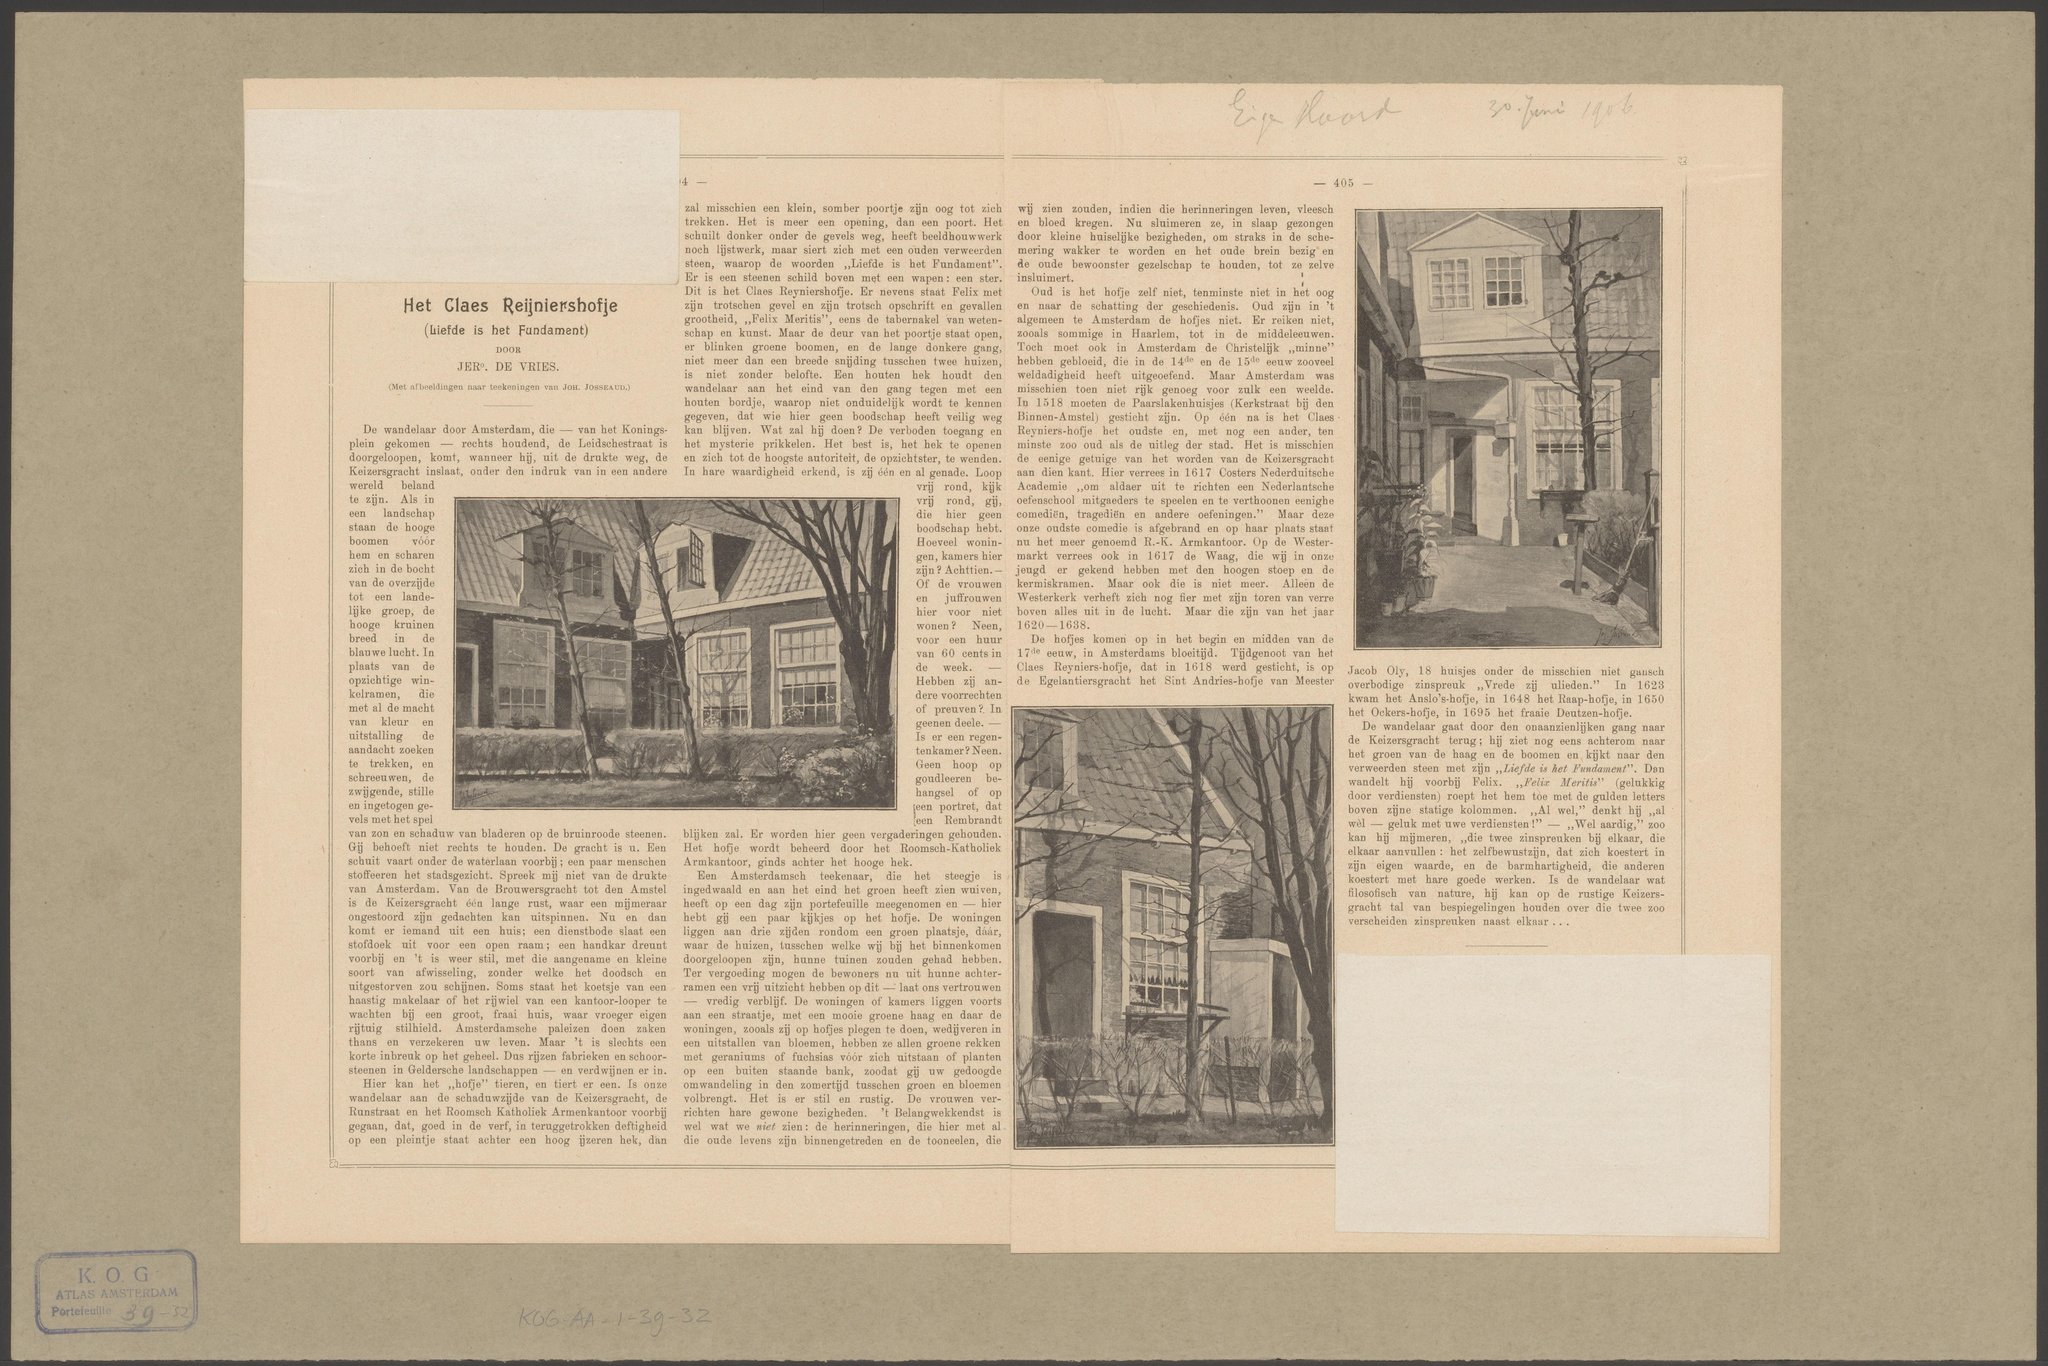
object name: photomechanical print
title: Het Claes Reijniershofje (Liefde is het Fundament)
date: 1906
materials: paper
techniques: letterpress printing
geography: amsterdam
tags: alms-house (dutch: 'hofje'), courtyard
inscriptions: collector's mark: Lugt 1641b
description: Object bestaat uit twee aan elkaar geplakte bladen. Onderwerpsrubriek binnen de Atlas Amsterdam: Armwezen en liefdadige instellingen: III. Verschillende gestichten en instellingen / Hofjes: Van Brienenhofje “de Star” - Bijbels Hofje - Claes Reyniershofje - Constantiahofje.